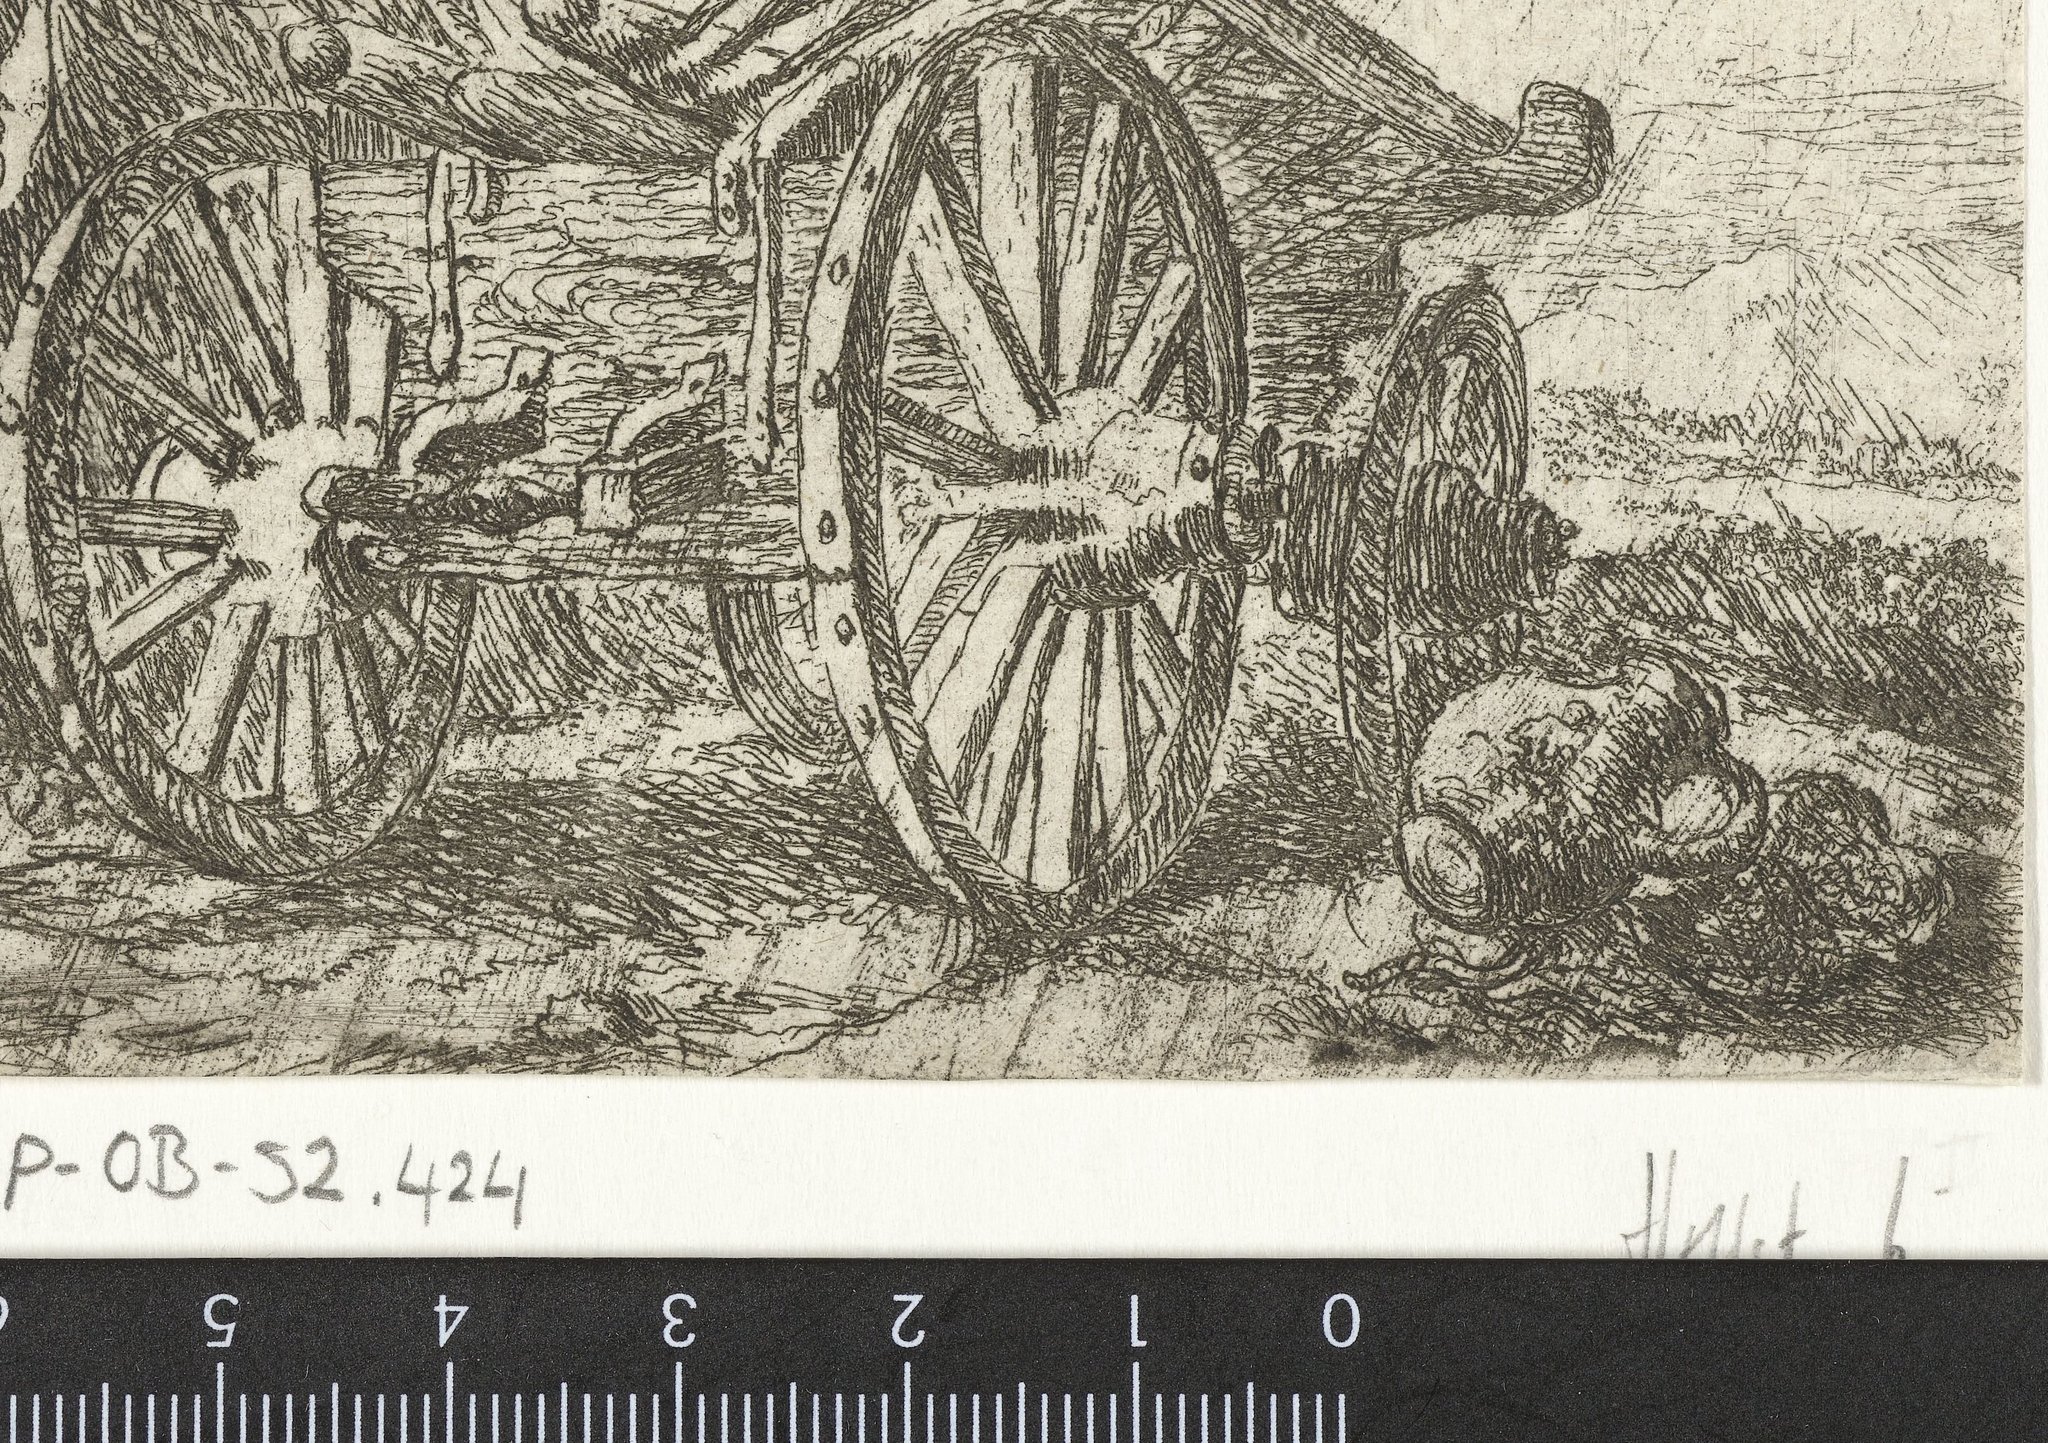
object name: print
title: Dieren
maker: joannes fijt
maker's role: draughtsman, print maker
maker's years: 1611-1661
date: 1621-1661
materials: paper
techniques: etching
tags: (farm) wagon, freight wagon, cart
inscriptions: collector's mark: Lugt 240